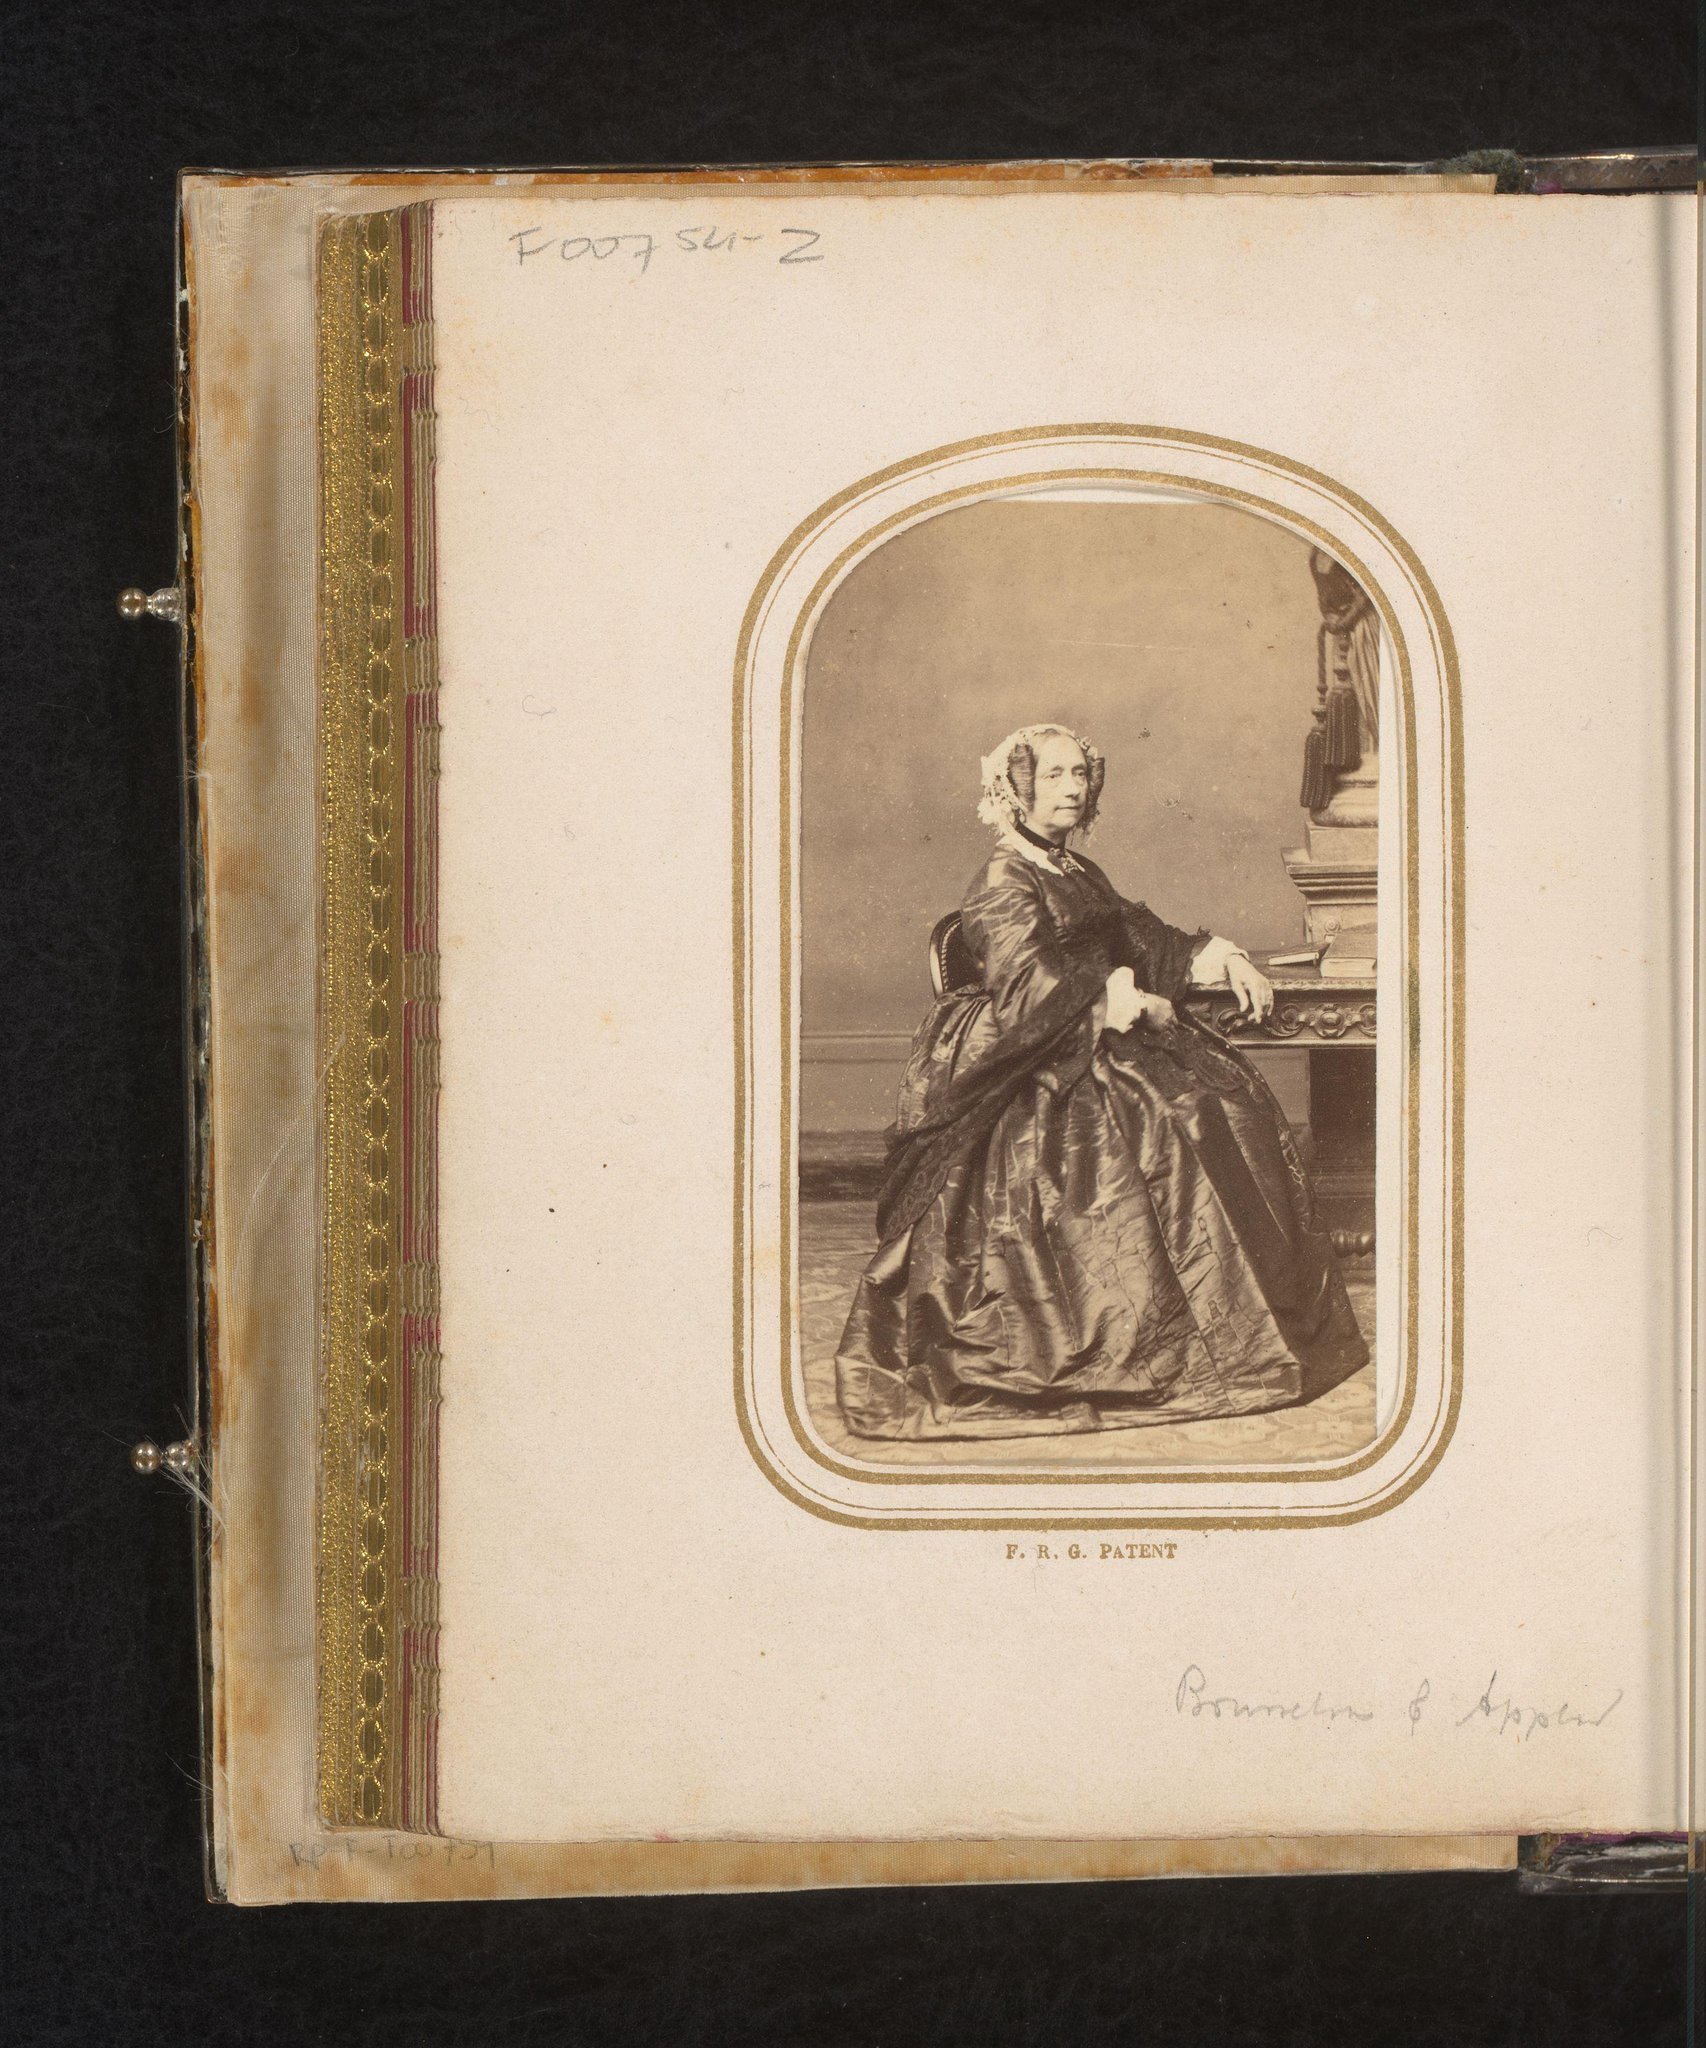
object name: photograph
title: Portret van een zittende vrouw met muts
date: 1855-1865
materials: cardboard, photographic support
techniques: albumen print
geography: paris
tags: historical persons - bb - woman, head-gear: cap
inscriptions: inscription: ‘Ancne Maison E. Defonds/ Bousseton & Appert/ peintres photographes (...) 21, Rue Louis le Grand/ au 1er étage/ Paris’